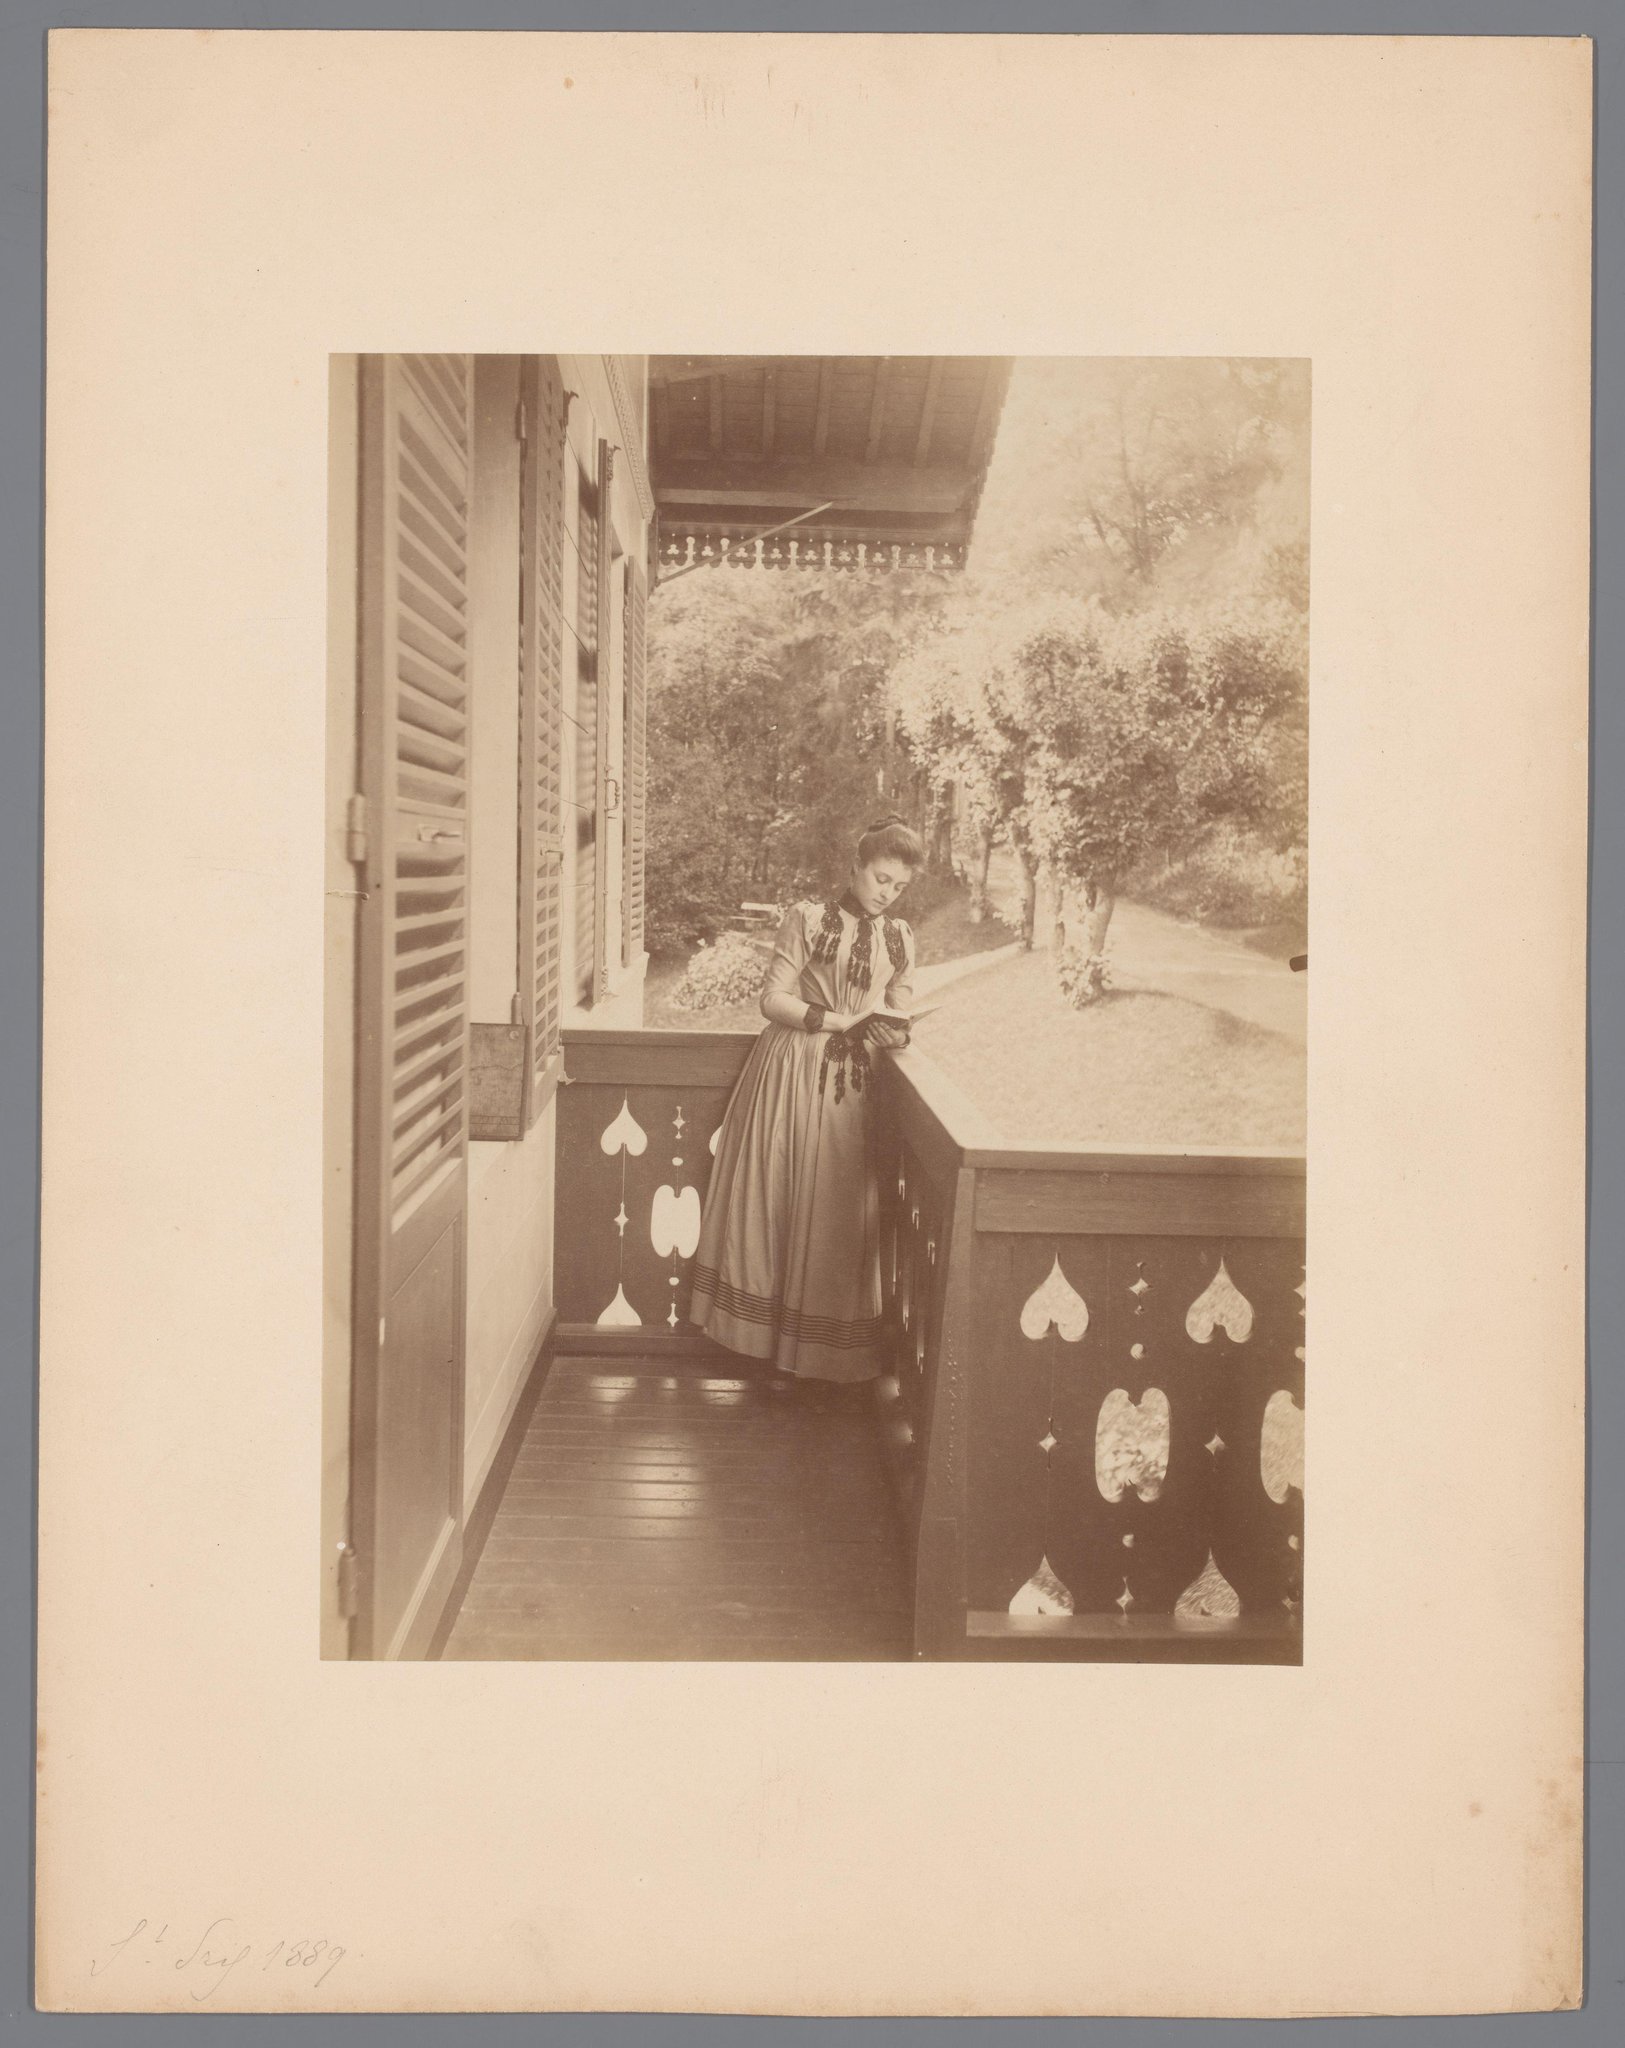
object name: photograph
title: Portret van een lezende jonge vrouw, staand op een veranda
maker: Anonymous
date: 1889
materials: cardboard, paper, photographic support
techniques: albumen print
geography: france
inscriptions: date: ‘1889’, annotation: ‘St Srig [onzeker] 1889’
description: Portret van een staande jonge vrouw, lezend op veranda met uitzicht op een tuin.